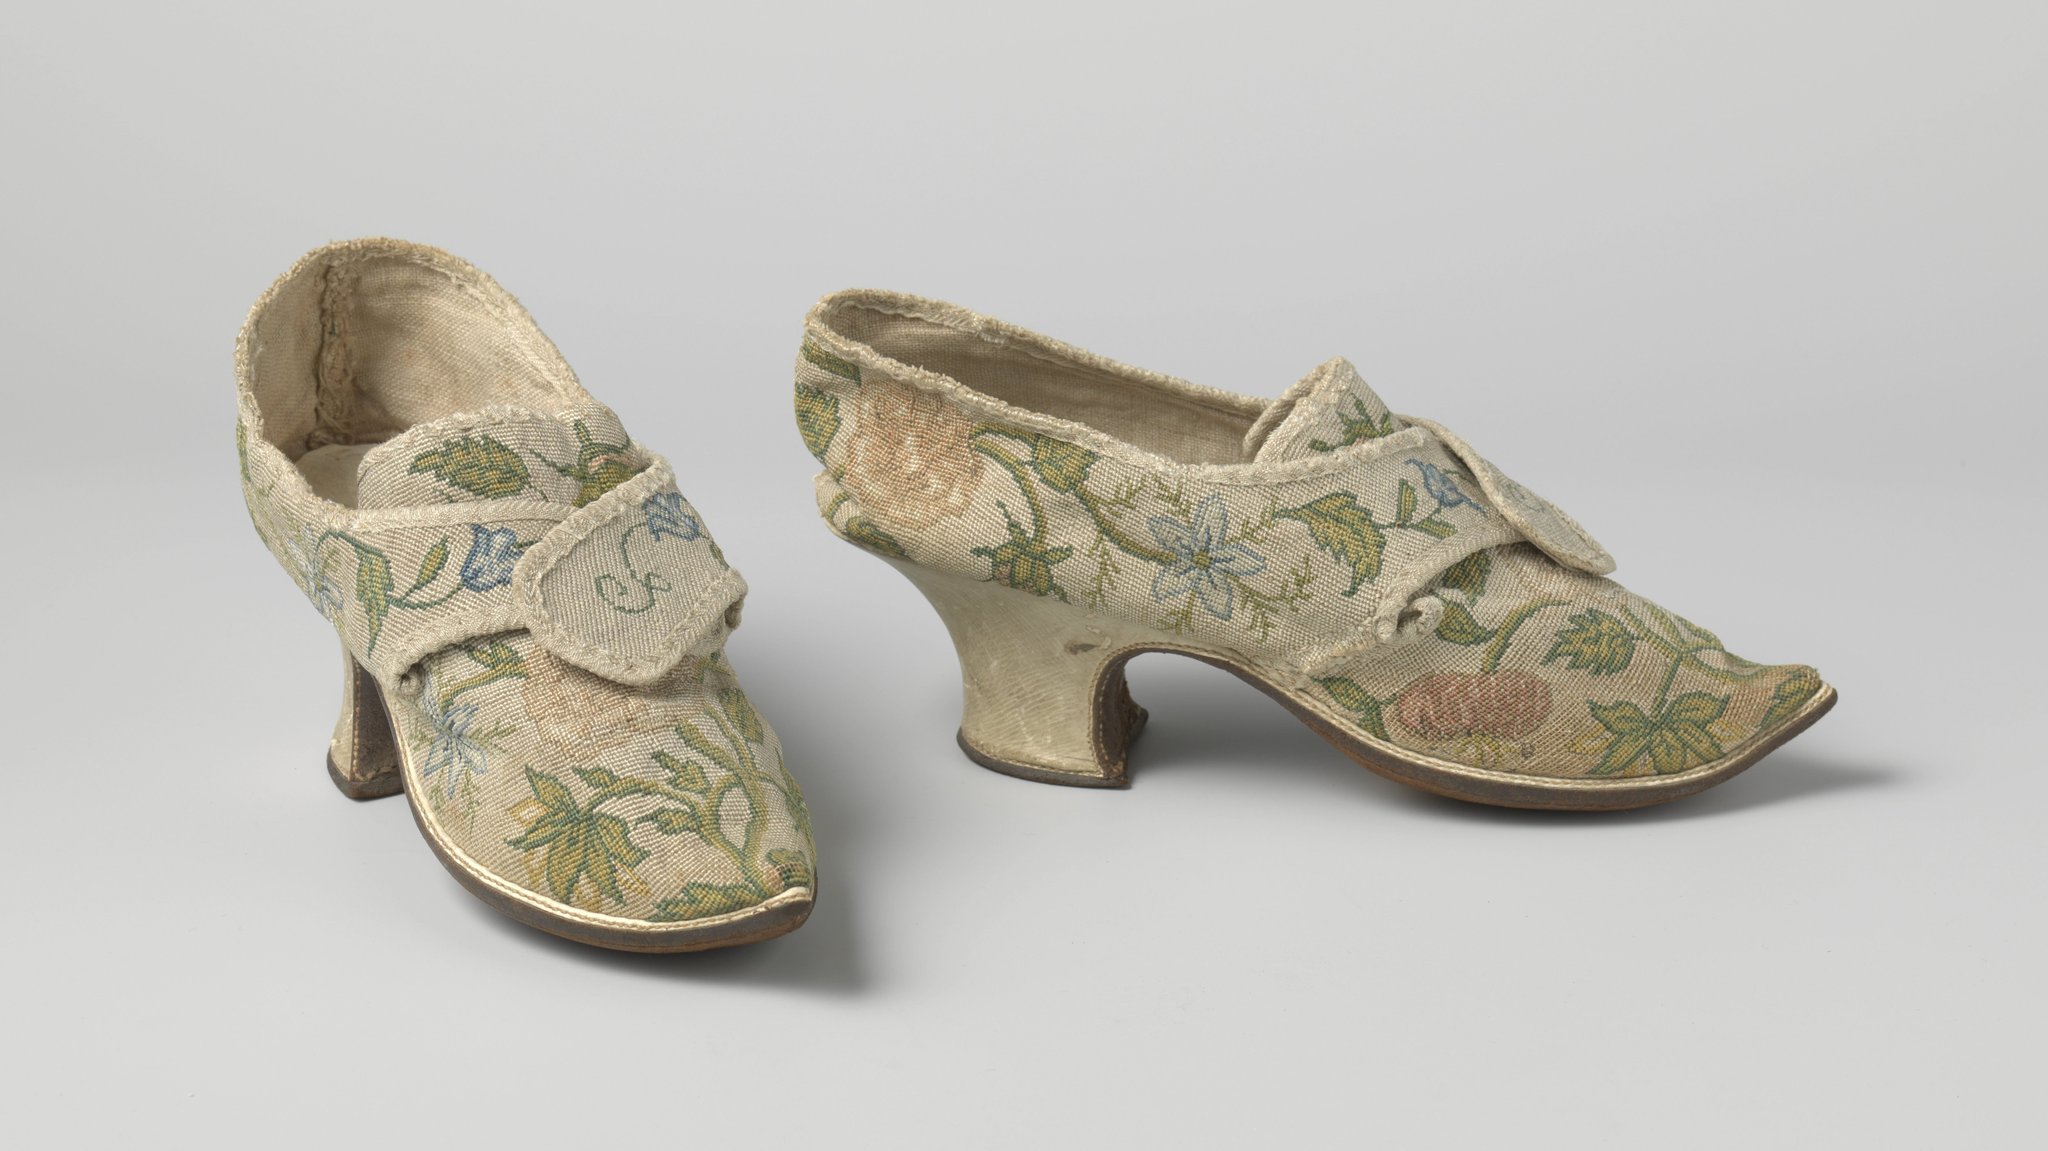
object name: shoe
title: Schoen met blad, tong en flappen van linnen, in petit point geborduurd met floraal motief van veelkleurige zijde; puntige neus en halfhoge hakken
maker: Anonymous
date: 1700-1725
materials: leather, linen, silk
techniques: embroidered, petit point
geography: netherlands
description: Model: schoen met opwippende, puntige neus en halfhoge hakken. Blad van linnen, gevoerd met grof linnen. De tong verdwijnt bijna geheel onder de twee over elkaar liggende flappen, die oorspronkelijk met een schoengesp werden gesloten. Tussen blad en zool een doorgestikte rand van hetzelfde witte geitenleer waar ook de hak mee bekleed is. Binnenzool van wit geitenleer. Versiering: het blad, de tong en de flappen zijn met veelkleurige zijde in petit point geborduurd met een floraal motief bestaande uit granaatappel (?), roos, vergeet-mij-niet, ranken met bladeren, roze-rode en blauwe bloemen.